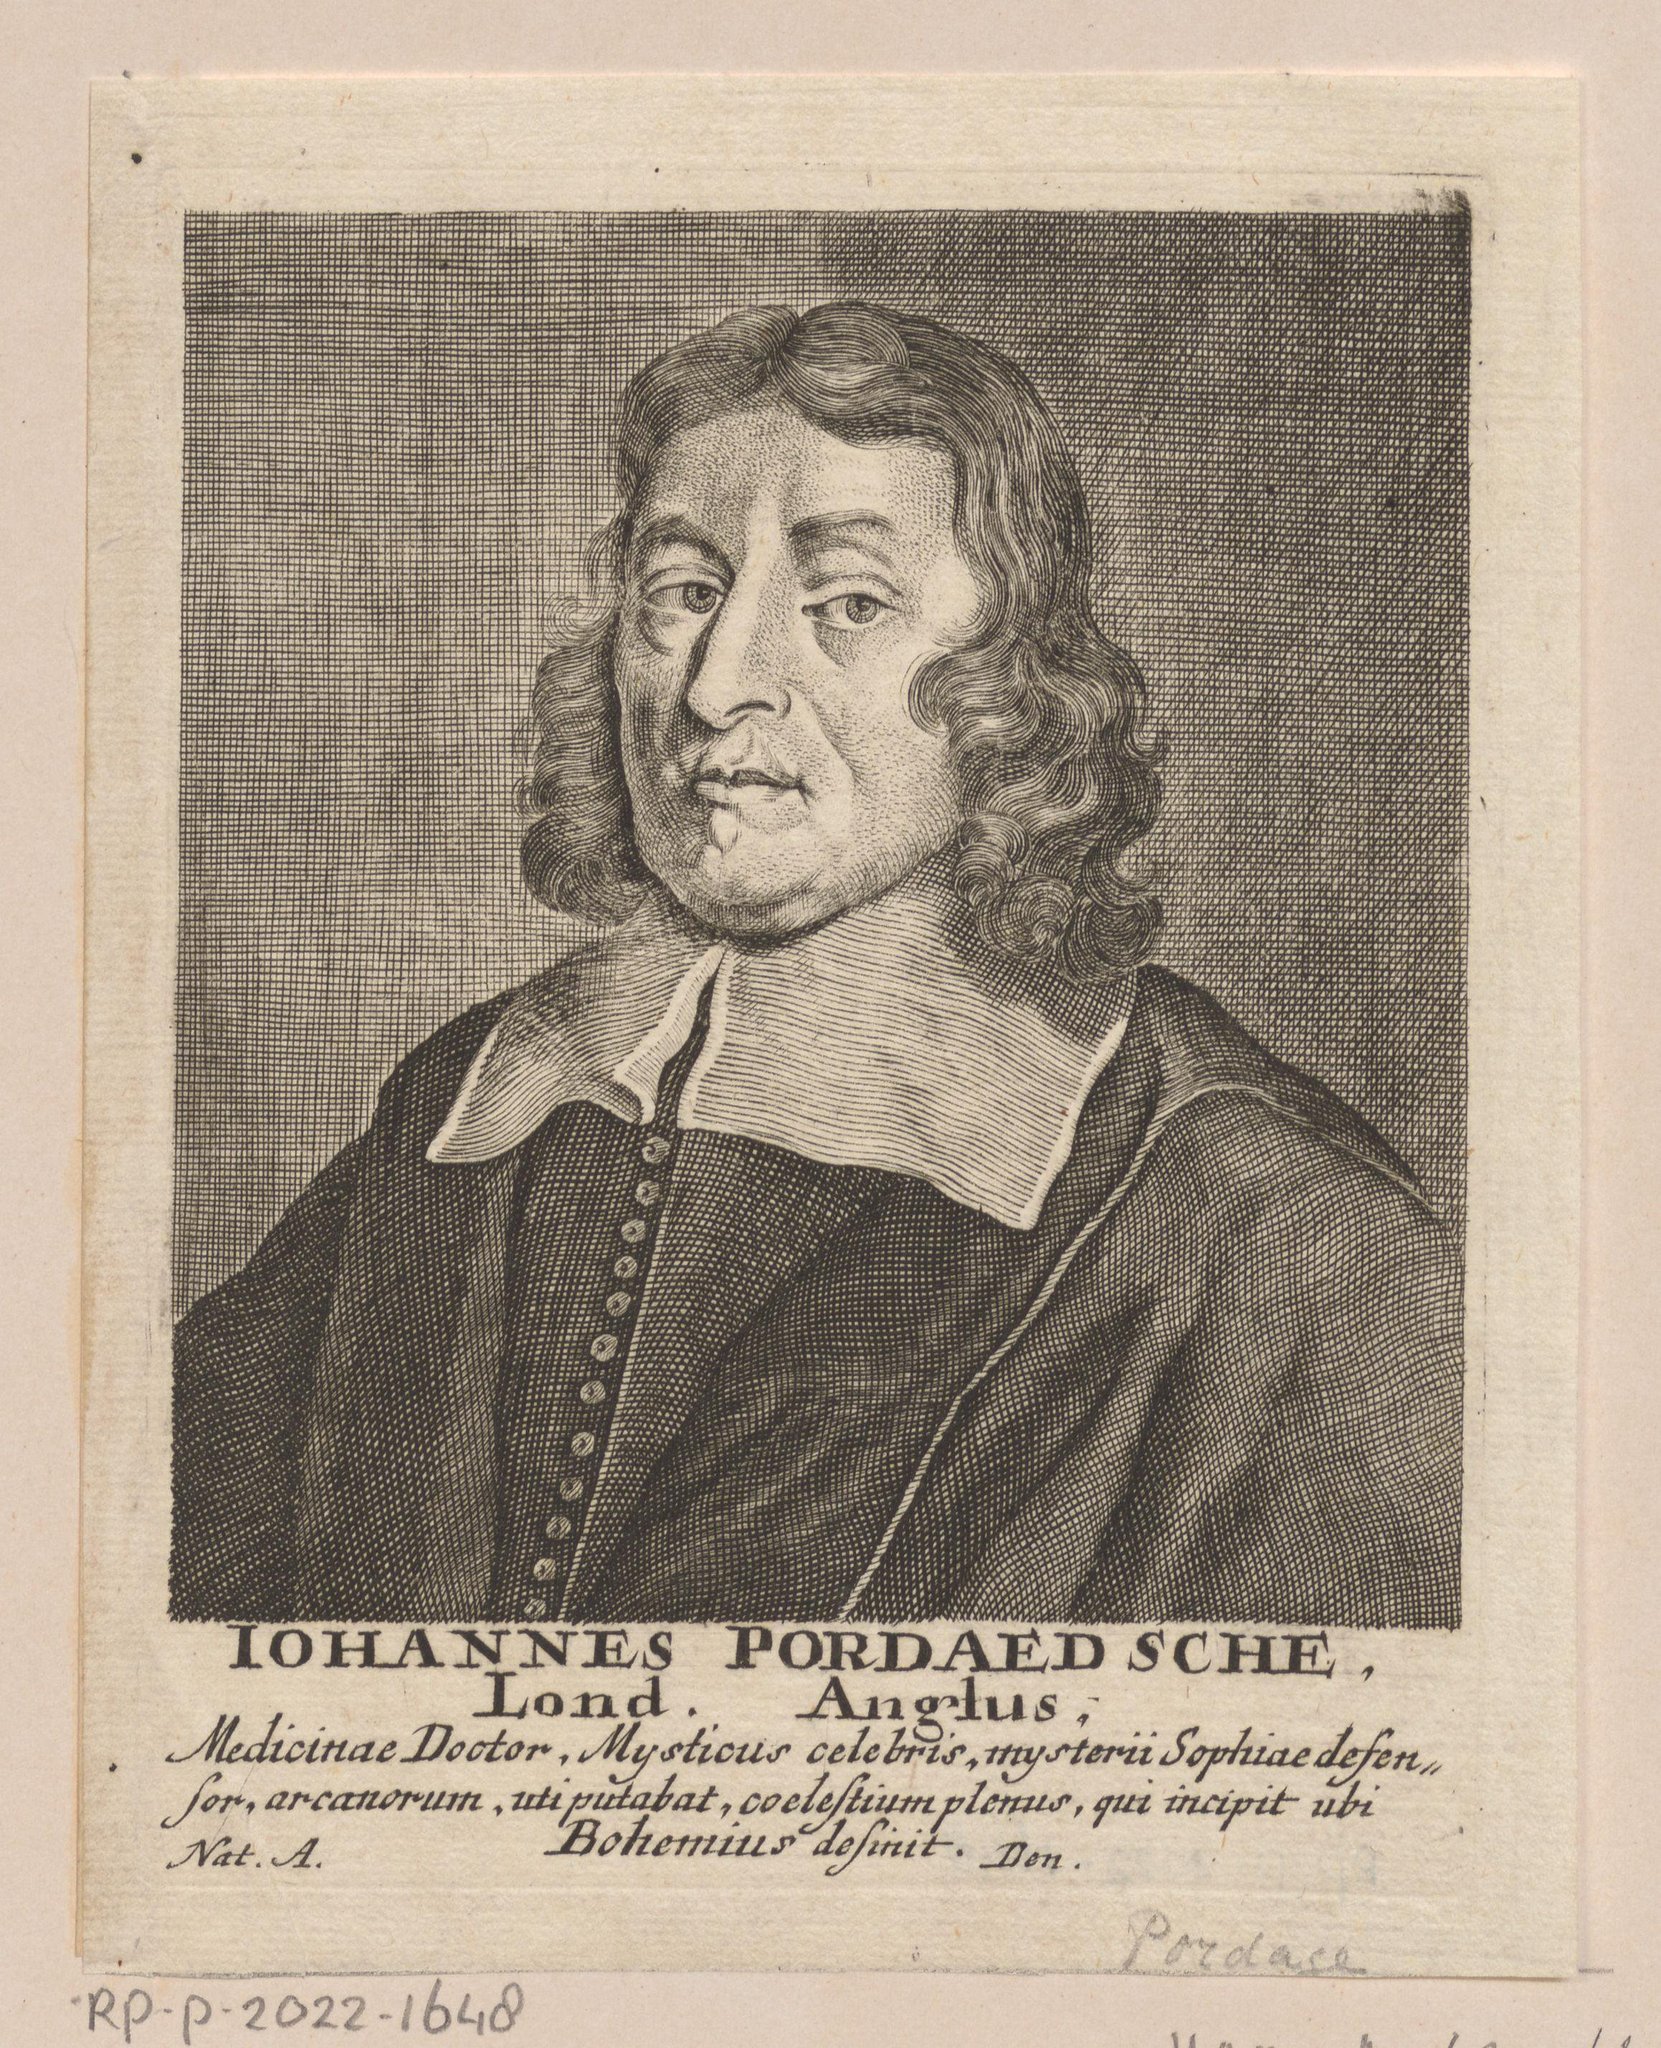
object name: print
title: Portret van John Pordage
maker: Anonymous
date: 1725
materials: paper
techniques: engraving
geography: nuremberg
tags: london, theologian, historical persons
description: Prent uit: Rothscholtz, Friedrich. Icones virorum omnium ordinum eruditione: omnique item genere et varietate artium de republica litteraria et speciatim de Academiis et Gymnasiis (...). Neurenberg: erven Johann Daniel Tauber, 1725, dl. 1 of 2.